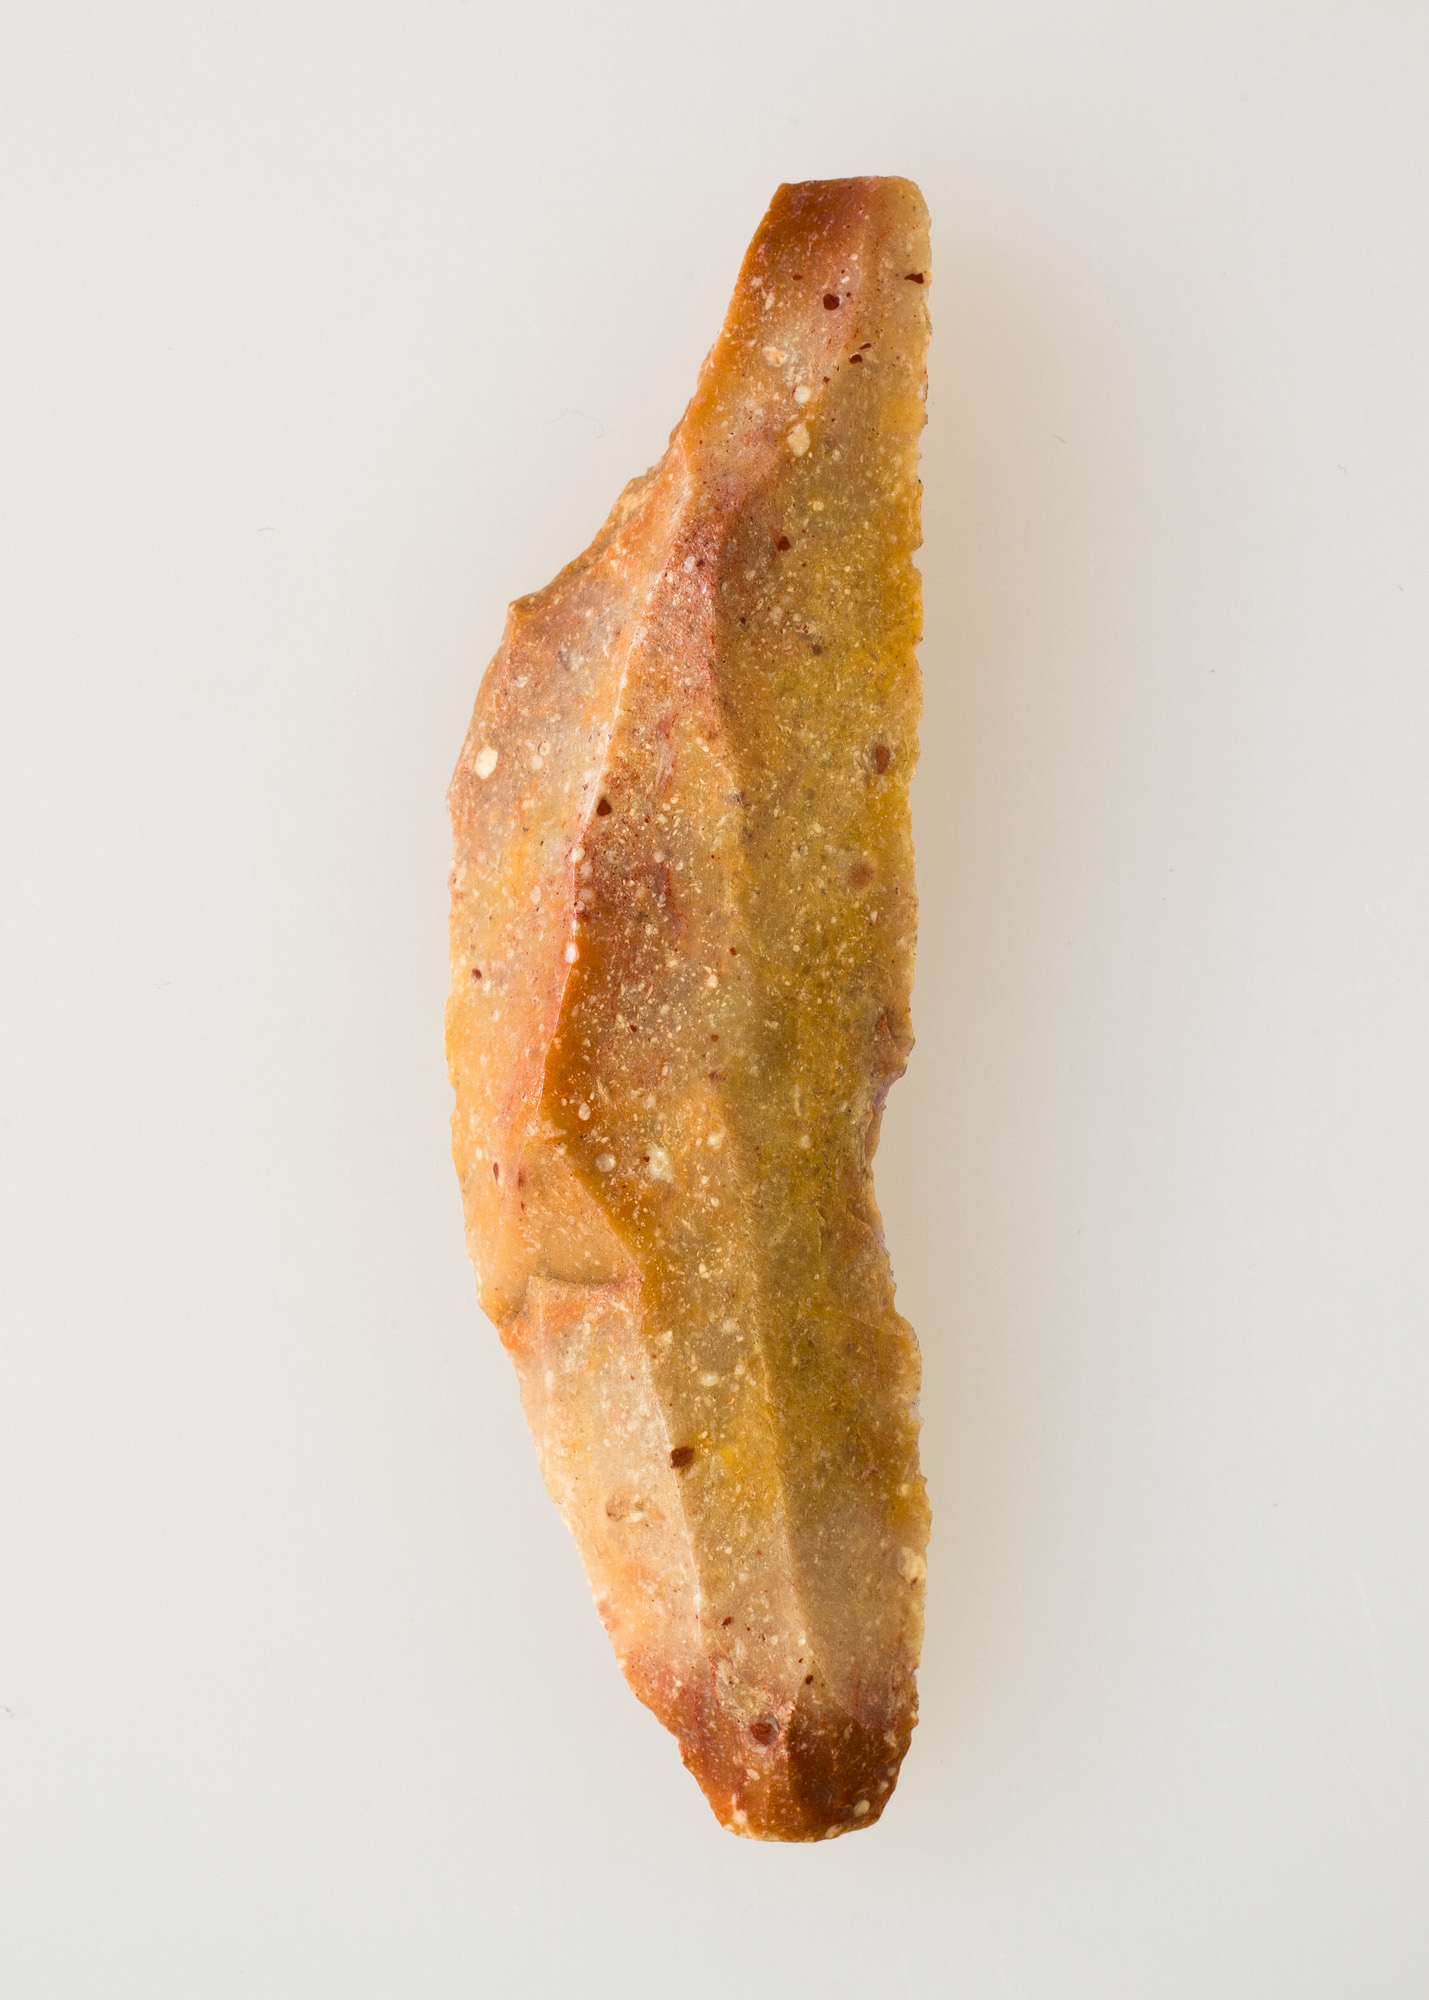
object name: retouched blade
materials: stone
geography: egypt